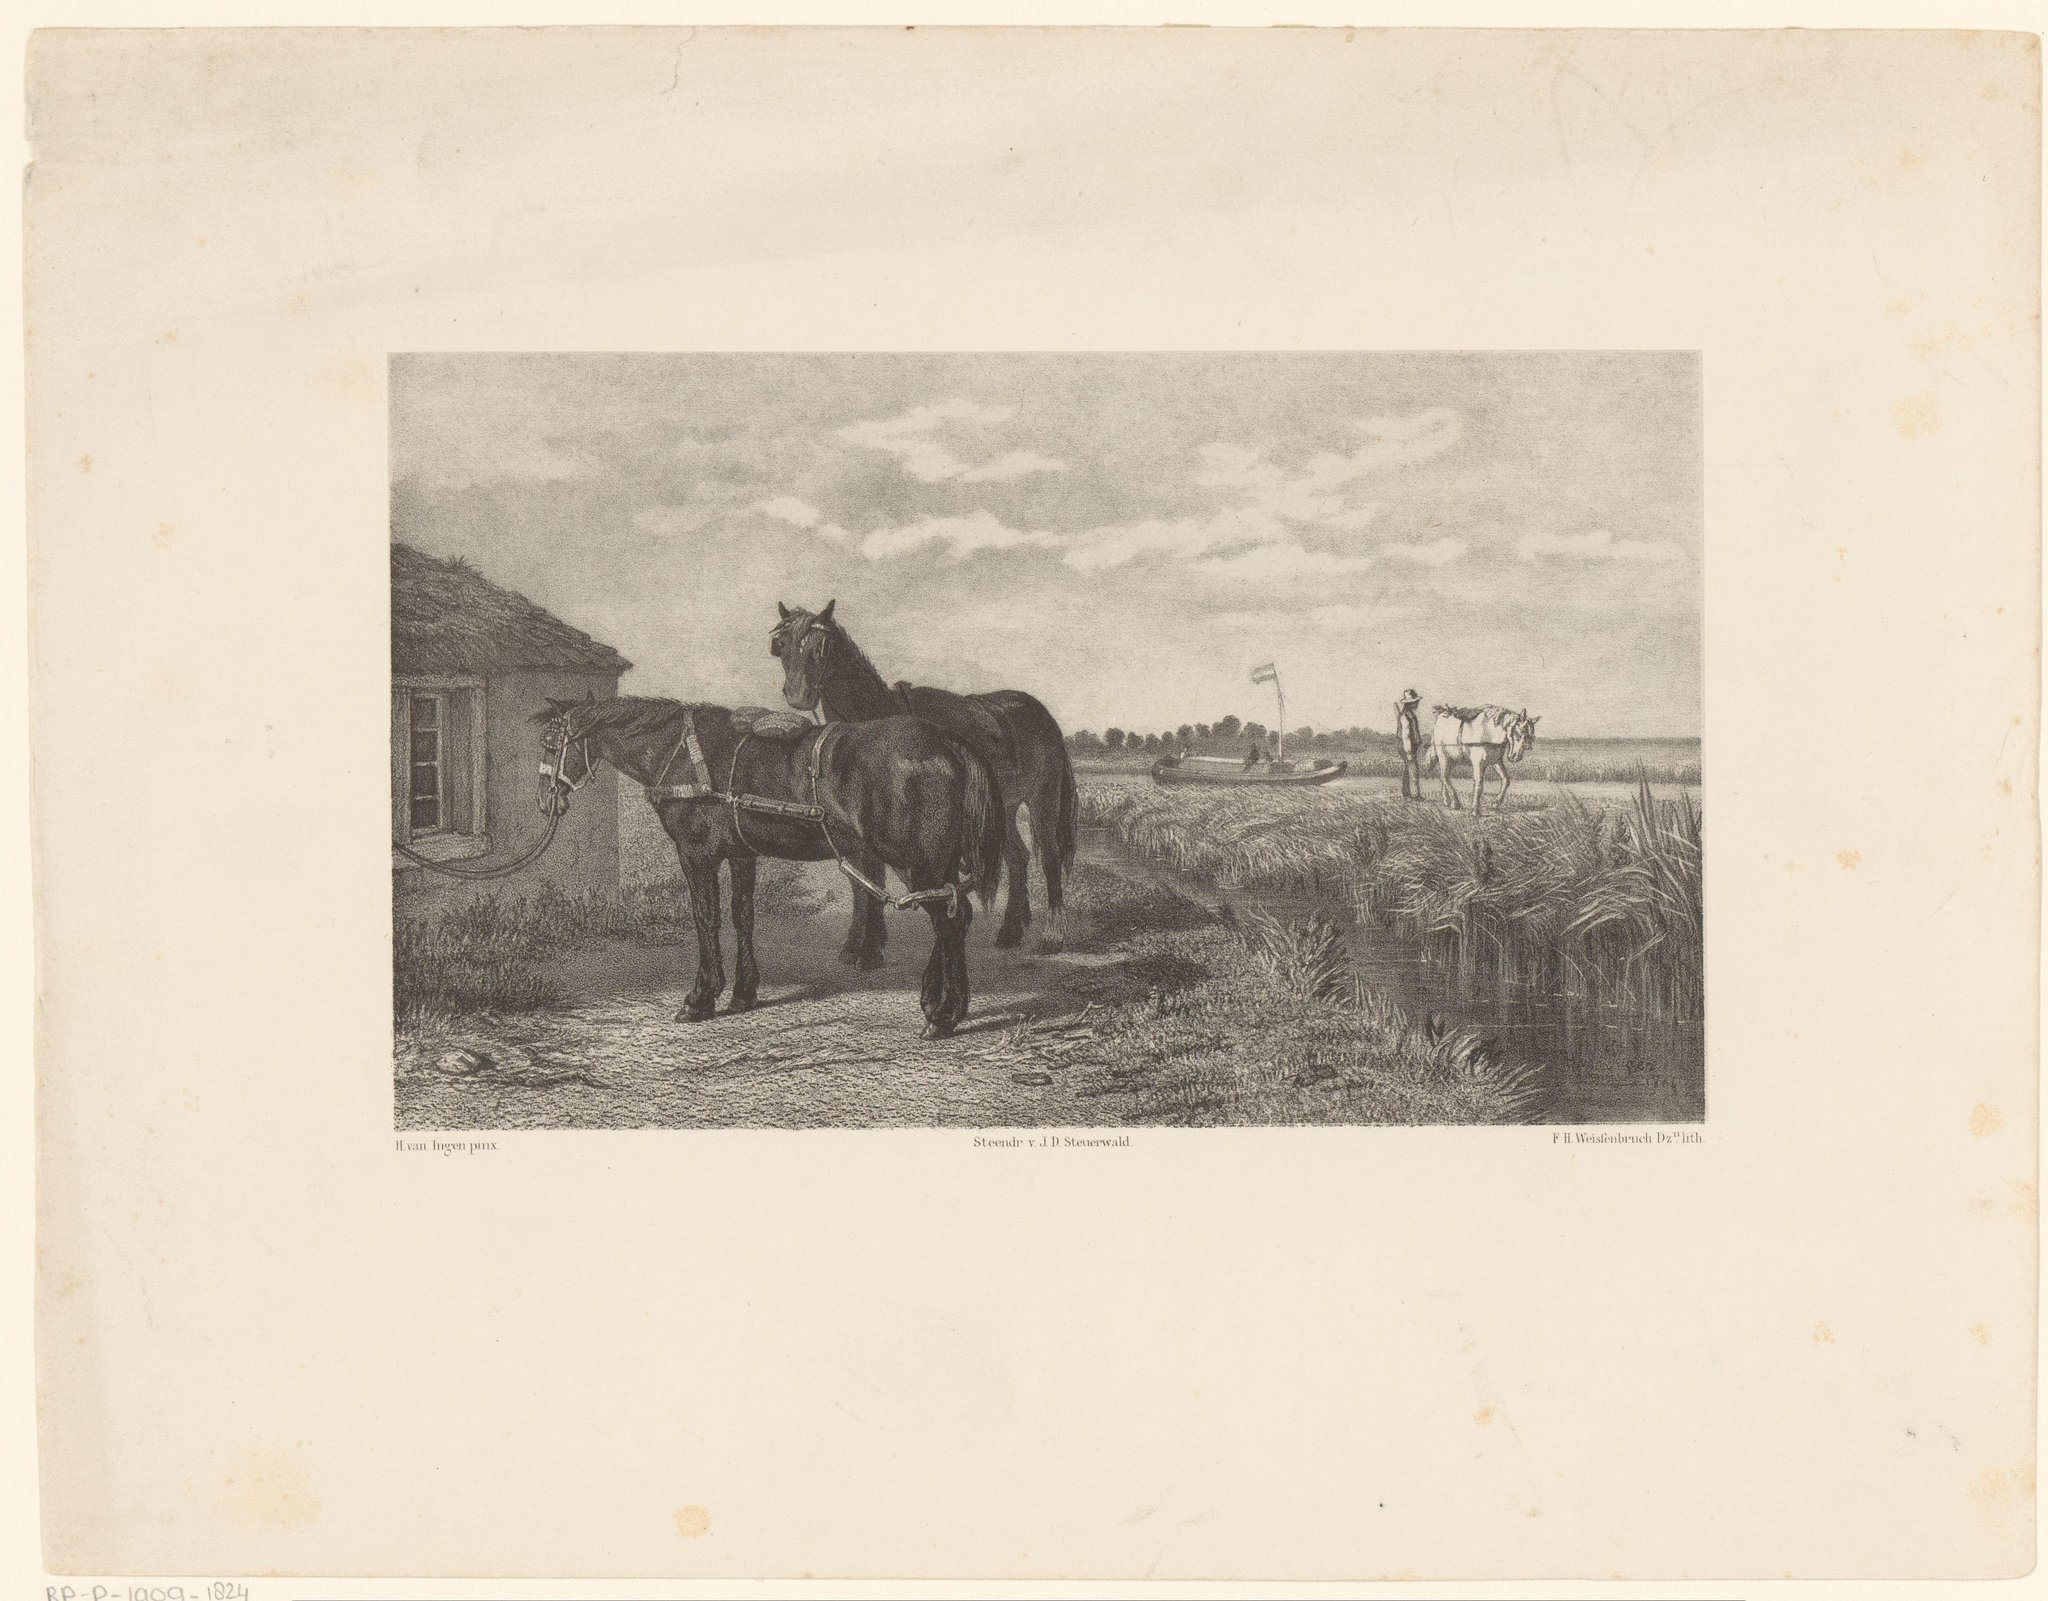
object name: print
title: Twee paarden voor een schuur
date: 1838-1863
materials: paper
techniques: lithograph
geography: the hague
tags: horse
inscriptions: collector's mark: Lugt 2228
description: Twee paarden staan te rusten voor een schuur. Rechts een schuit op een vaart, voortgetrokken door een paard.